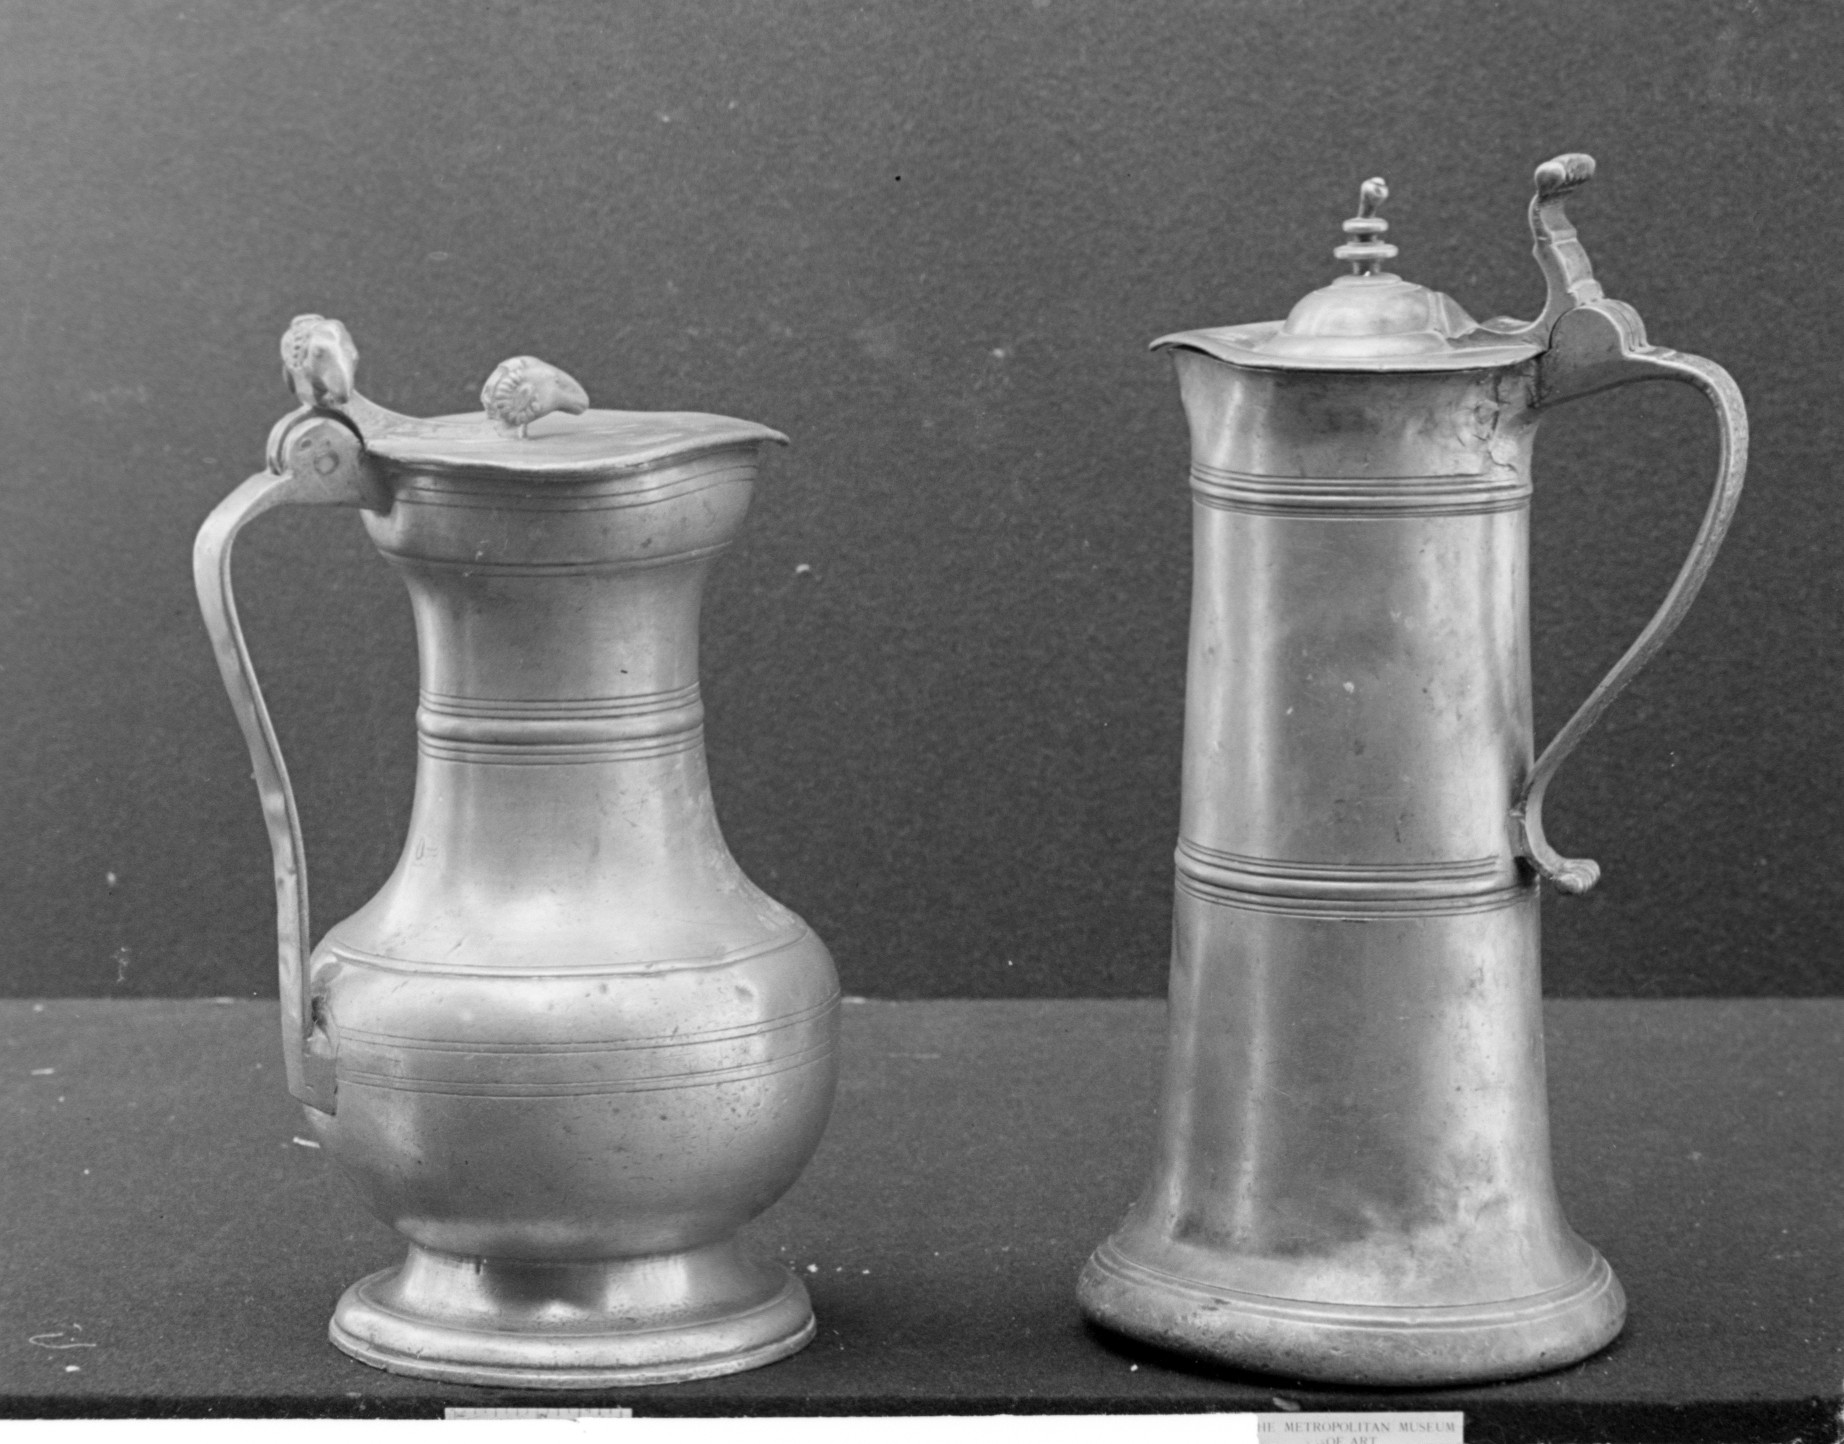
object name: flagon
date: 1667-1700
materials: pewter